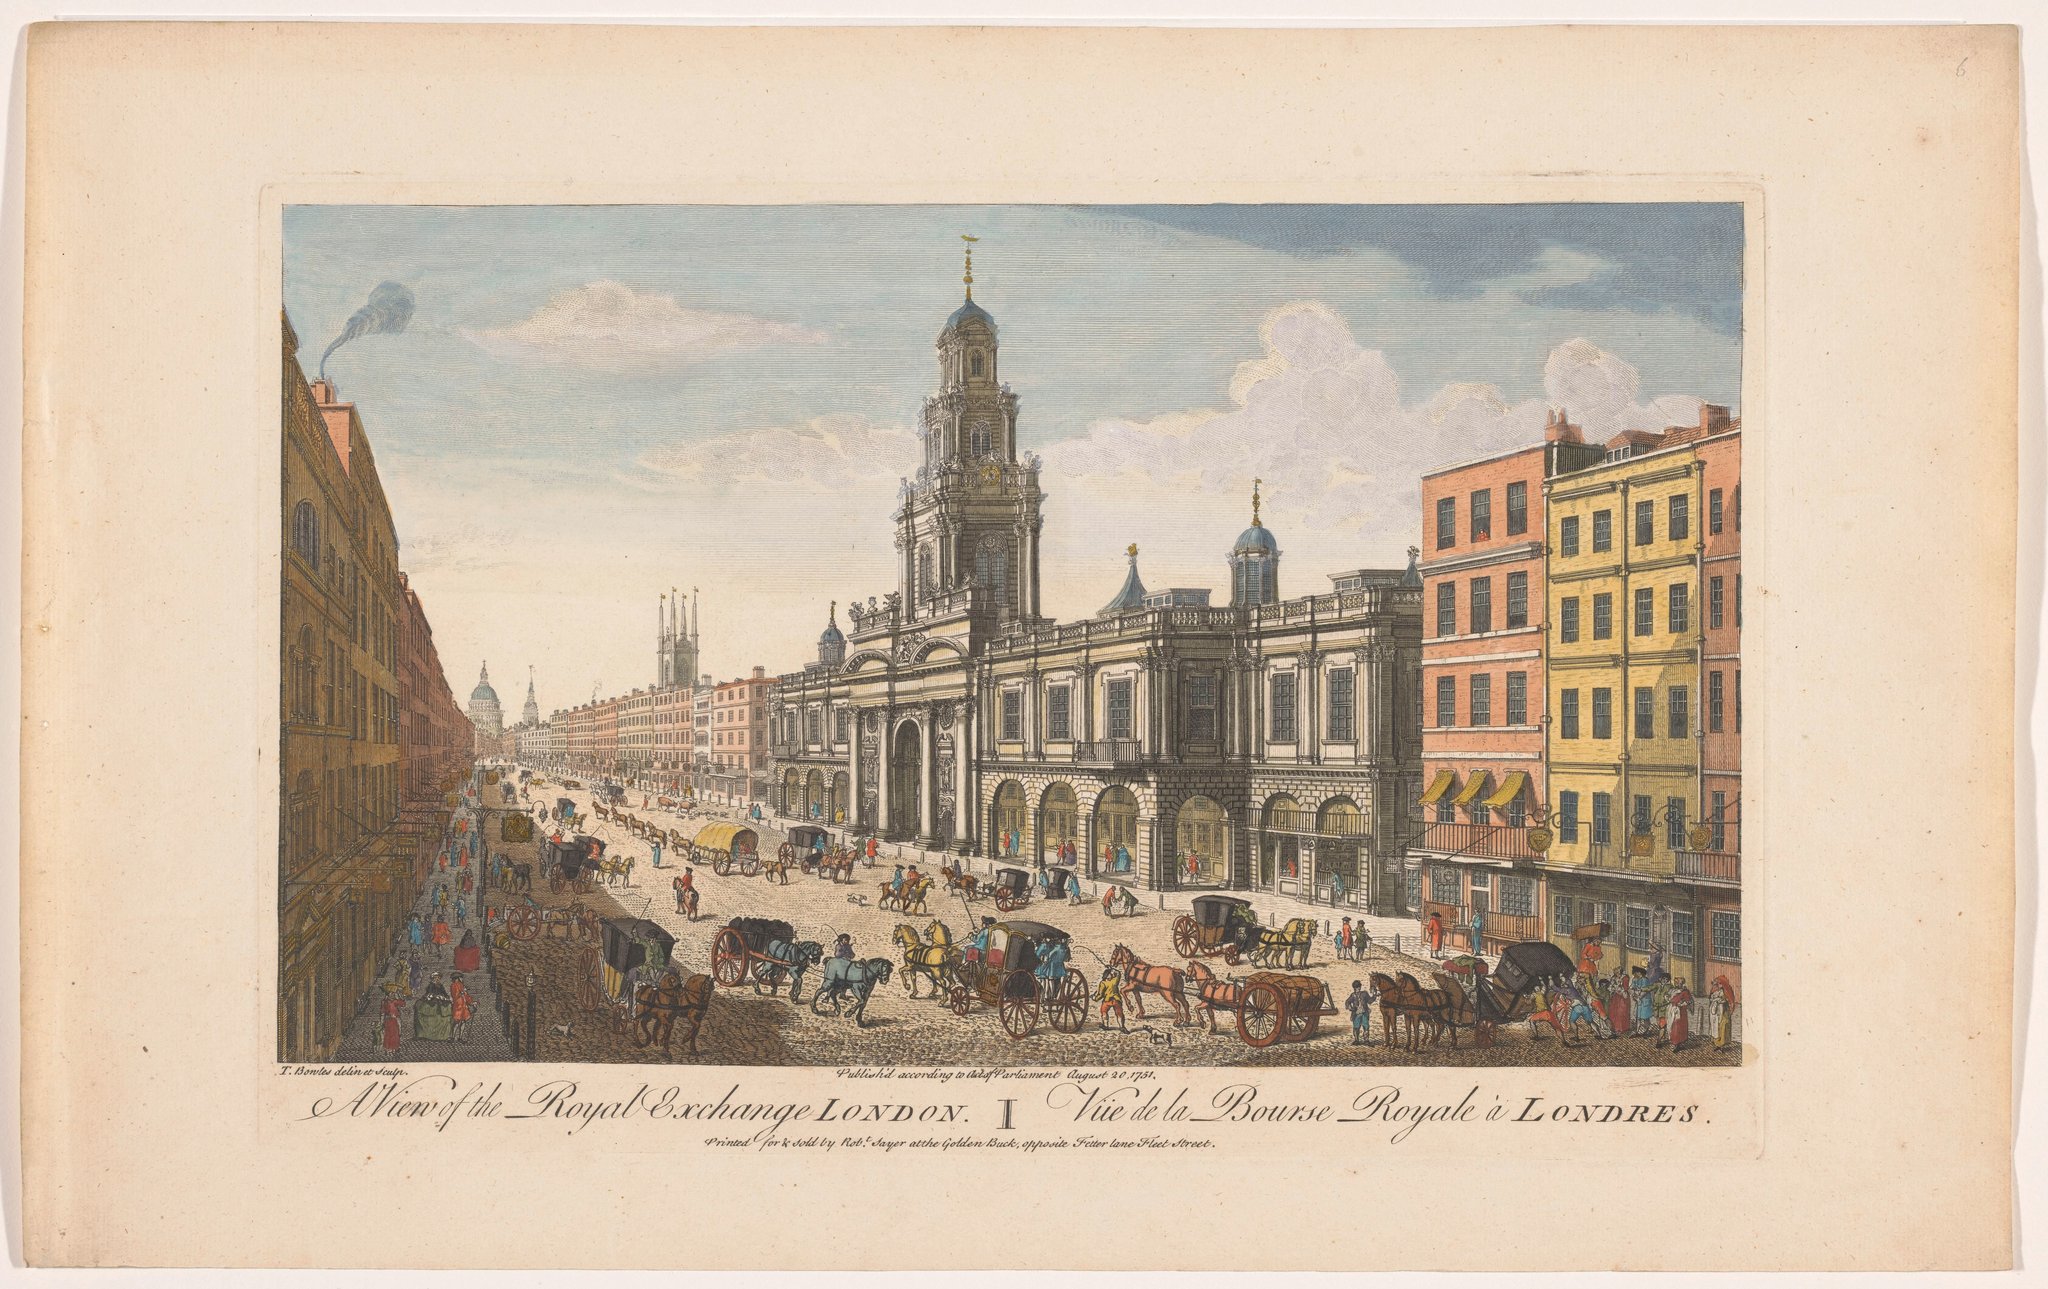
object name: opticaprent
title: Londen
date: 1751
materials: paper, watercolor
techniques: brush, etching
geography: london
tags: stock exchange, stock-market, street (+ city(-scape) with figures, staffage)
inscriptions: date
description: De serie “Londen” bevat 52 prenten met de nummers 1-52, waarvan dit nummer 6 is.